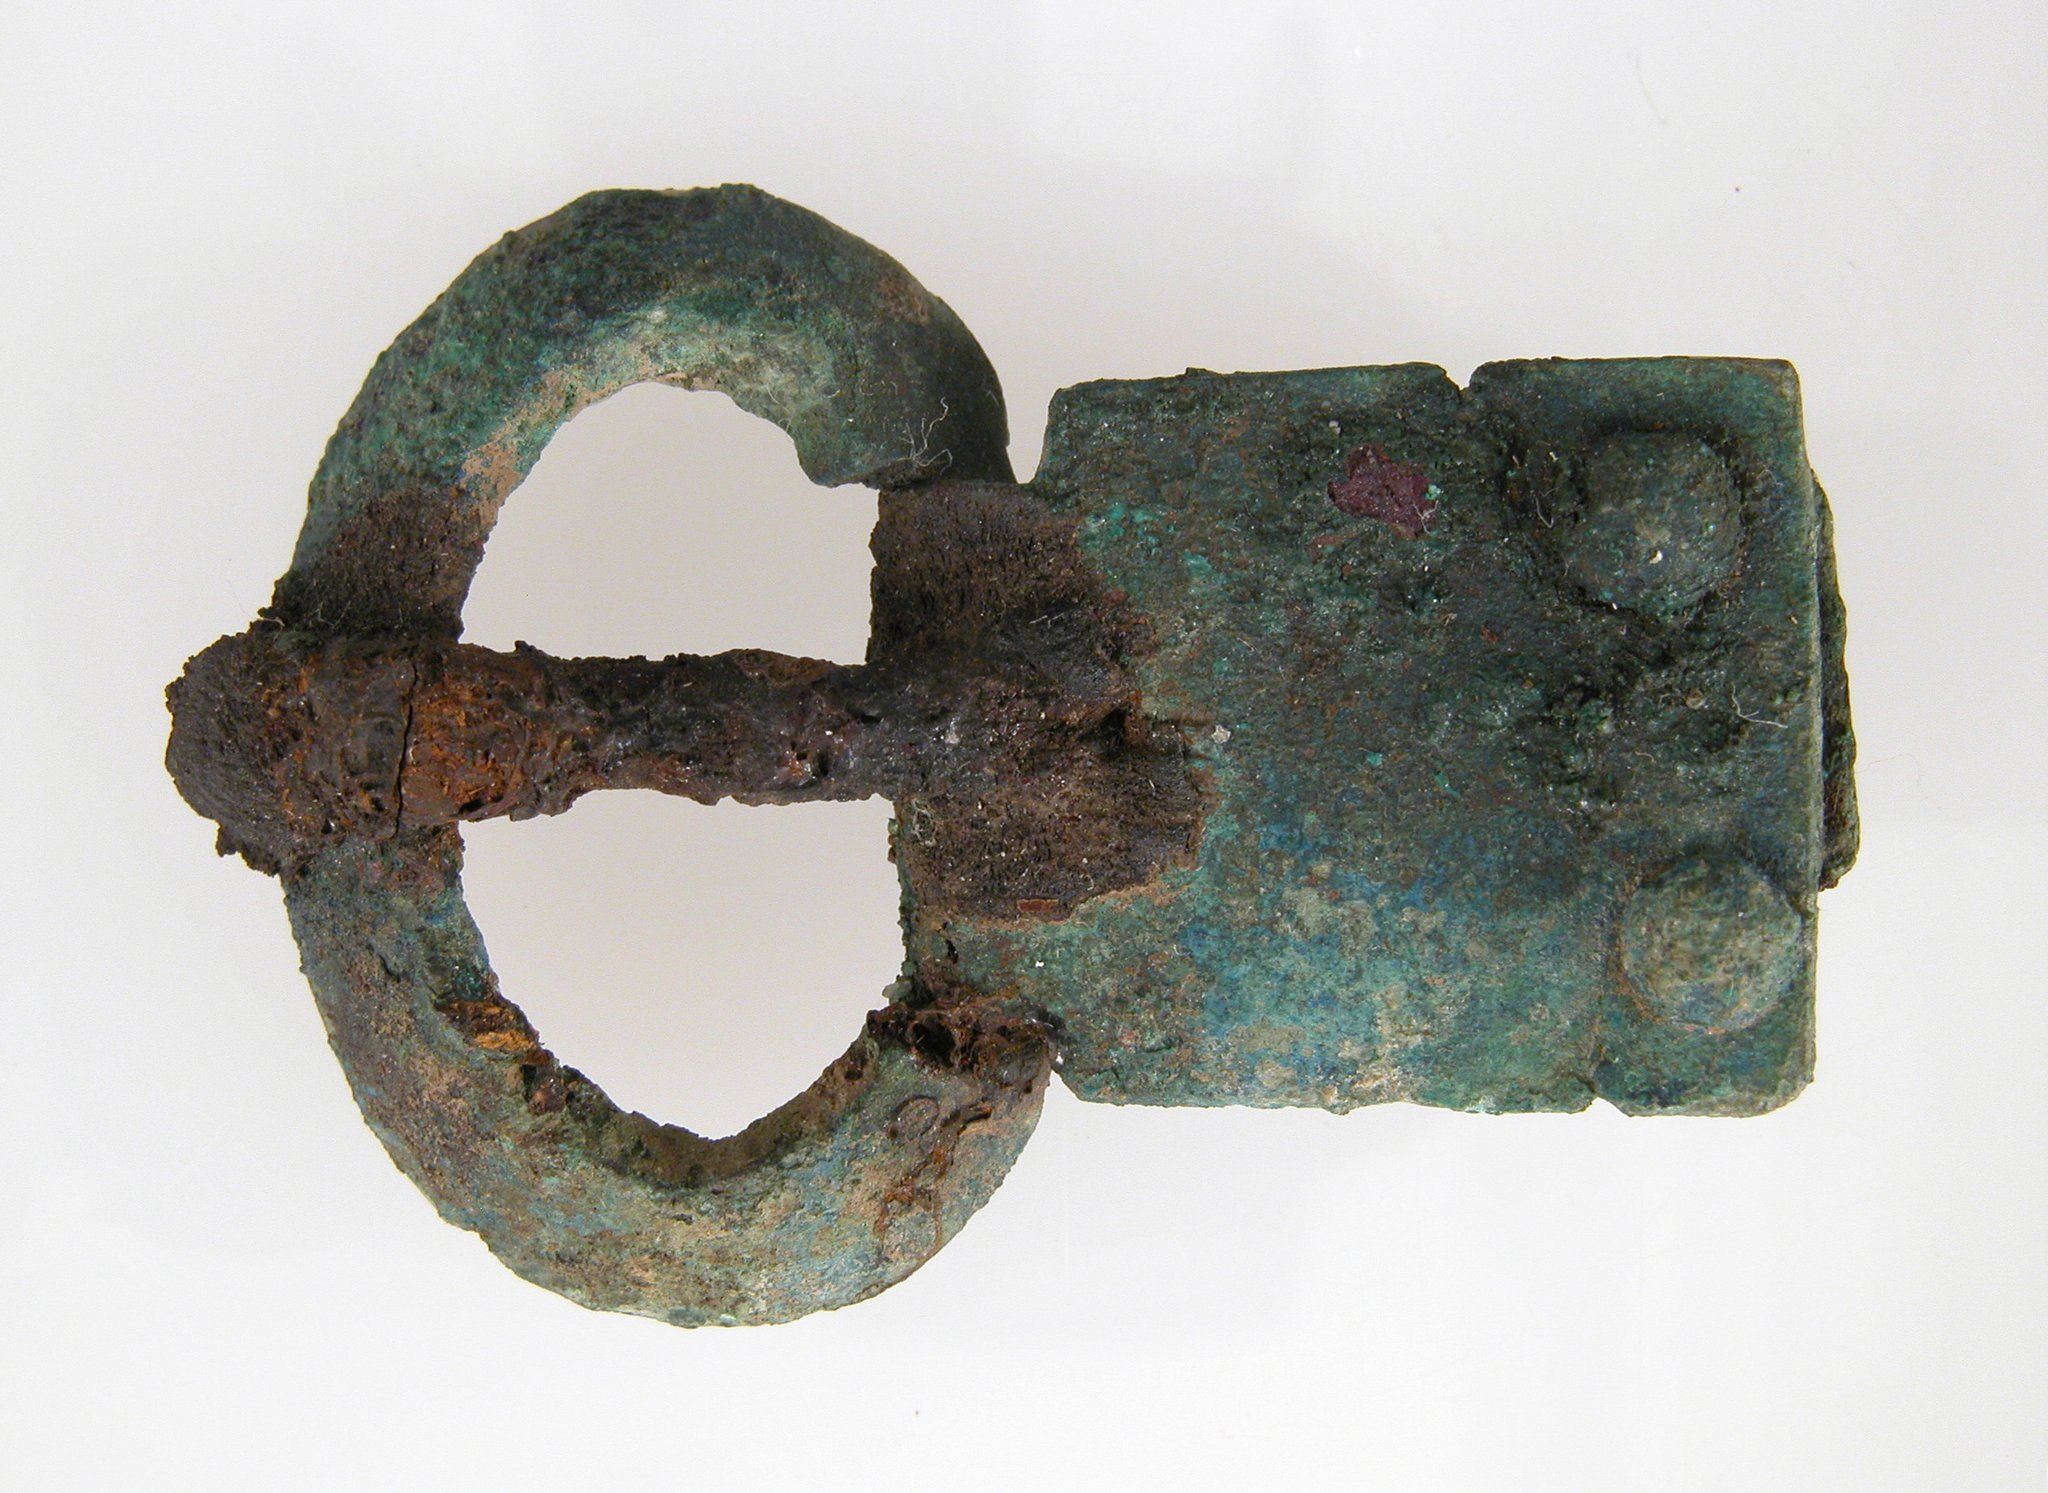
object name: buckle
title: Small Buckle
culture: frankish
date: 601-700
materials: copper alloy, iron